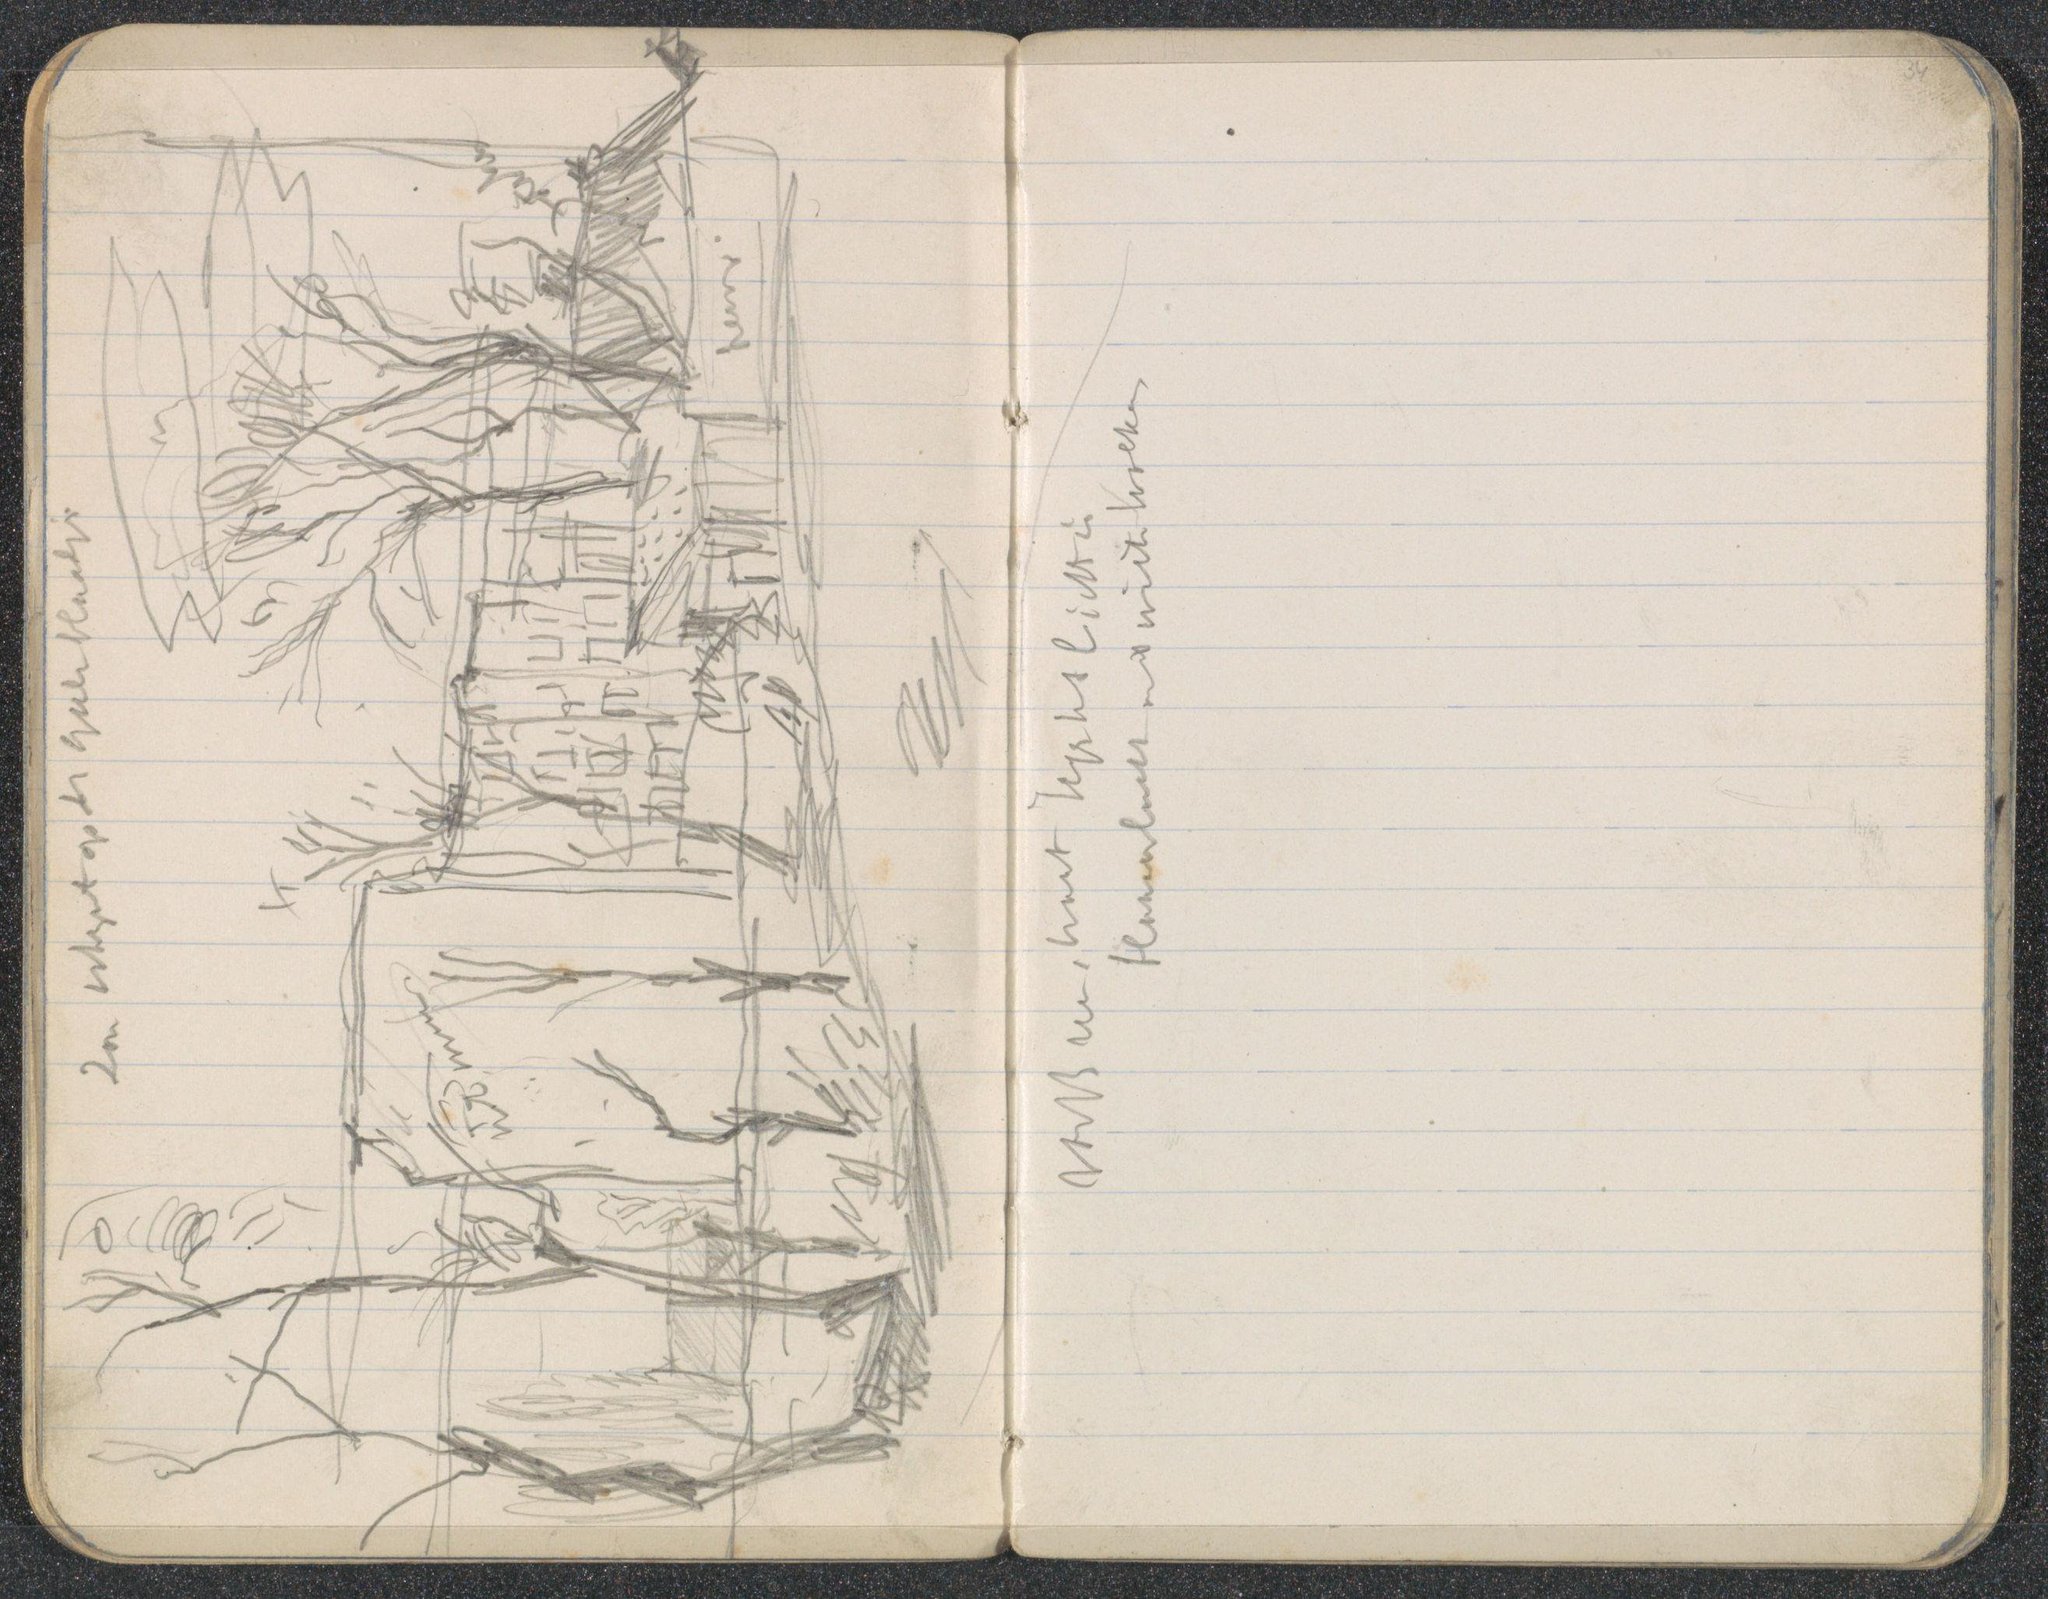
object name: sketchbook leaf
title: Gezicht op de Van Breestraat in Amsterdam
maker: george hendrik breitner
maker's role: draughtsman, painter, print maker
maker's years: 1857-1923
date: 1899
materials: pencil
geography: amsterdam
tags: trees, civic architecture; edifices; dwellings, street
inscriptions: annotation: ‘zon schijnt op de geele blaadjes/ Van Breestraat tegen het licht in/ blaauwe lucht met witte wolken’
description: Achterzijde van de huizen aan de Jan Willem Brouwersstraat 24-32 en de Johannes Verhulststraat 2-14 bij het begin van de toekomstige Wannigstraat. Pagina 33 en pagina 34 uit een schetsboek met 39 bladen.